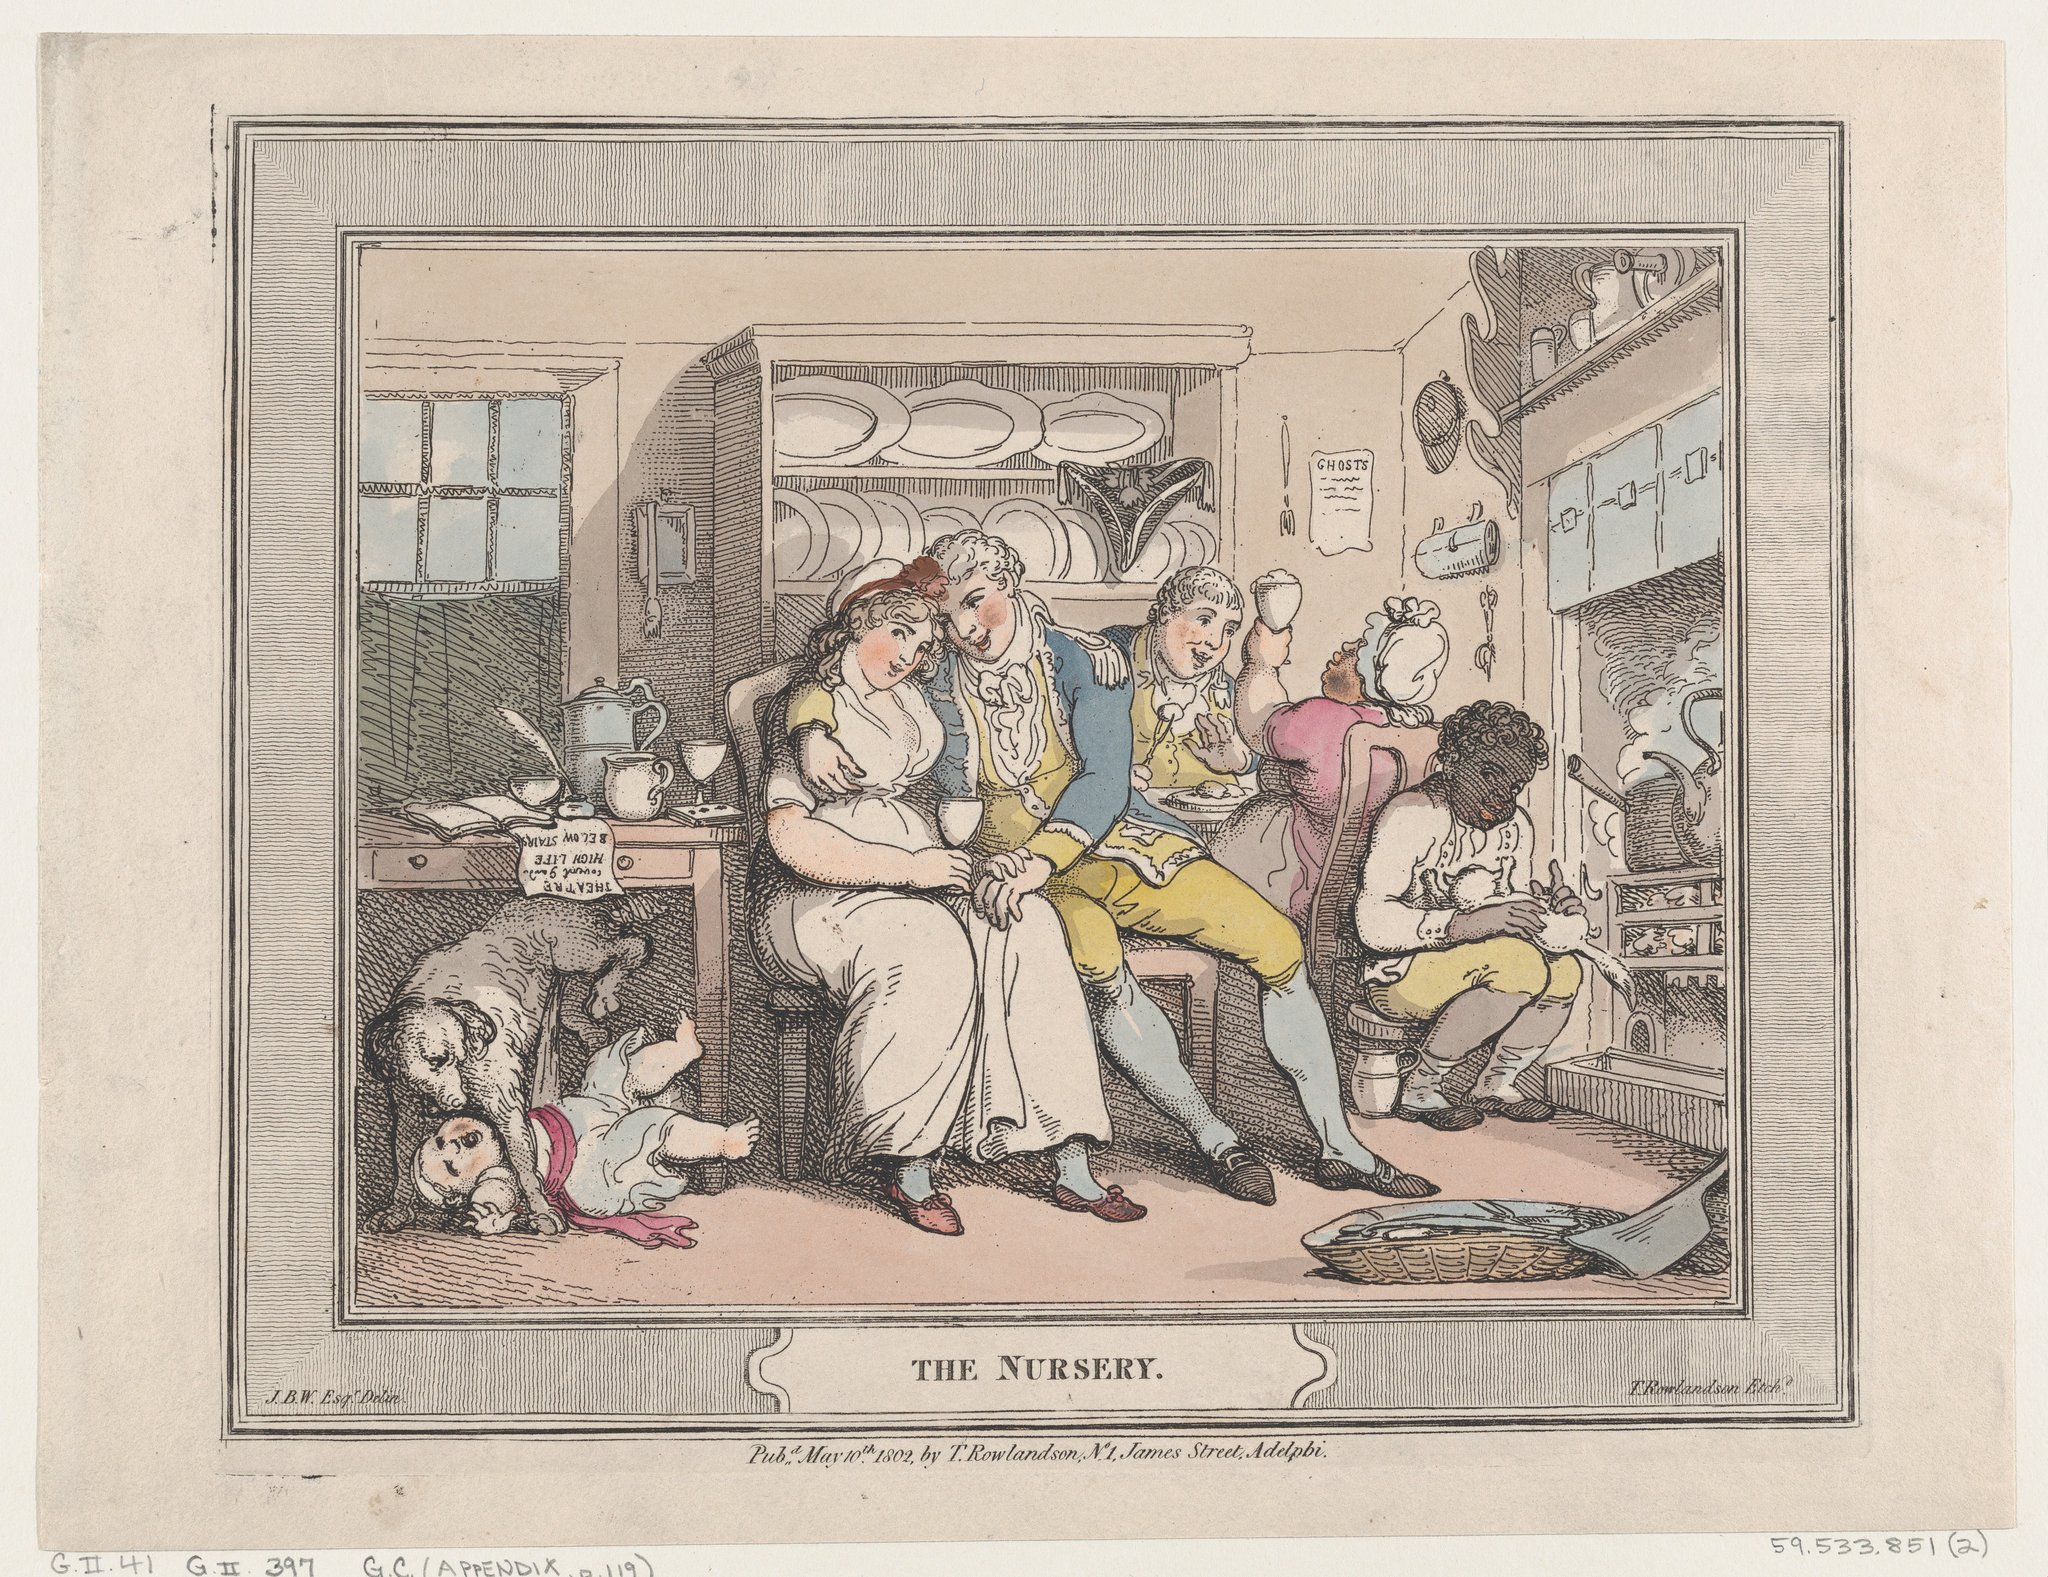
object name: print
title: The Nursery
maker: thomas rowlandson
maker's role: artist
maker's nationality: british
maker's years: 1757-1827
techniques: etching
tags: satire,kitchens,children,men,women,dogs